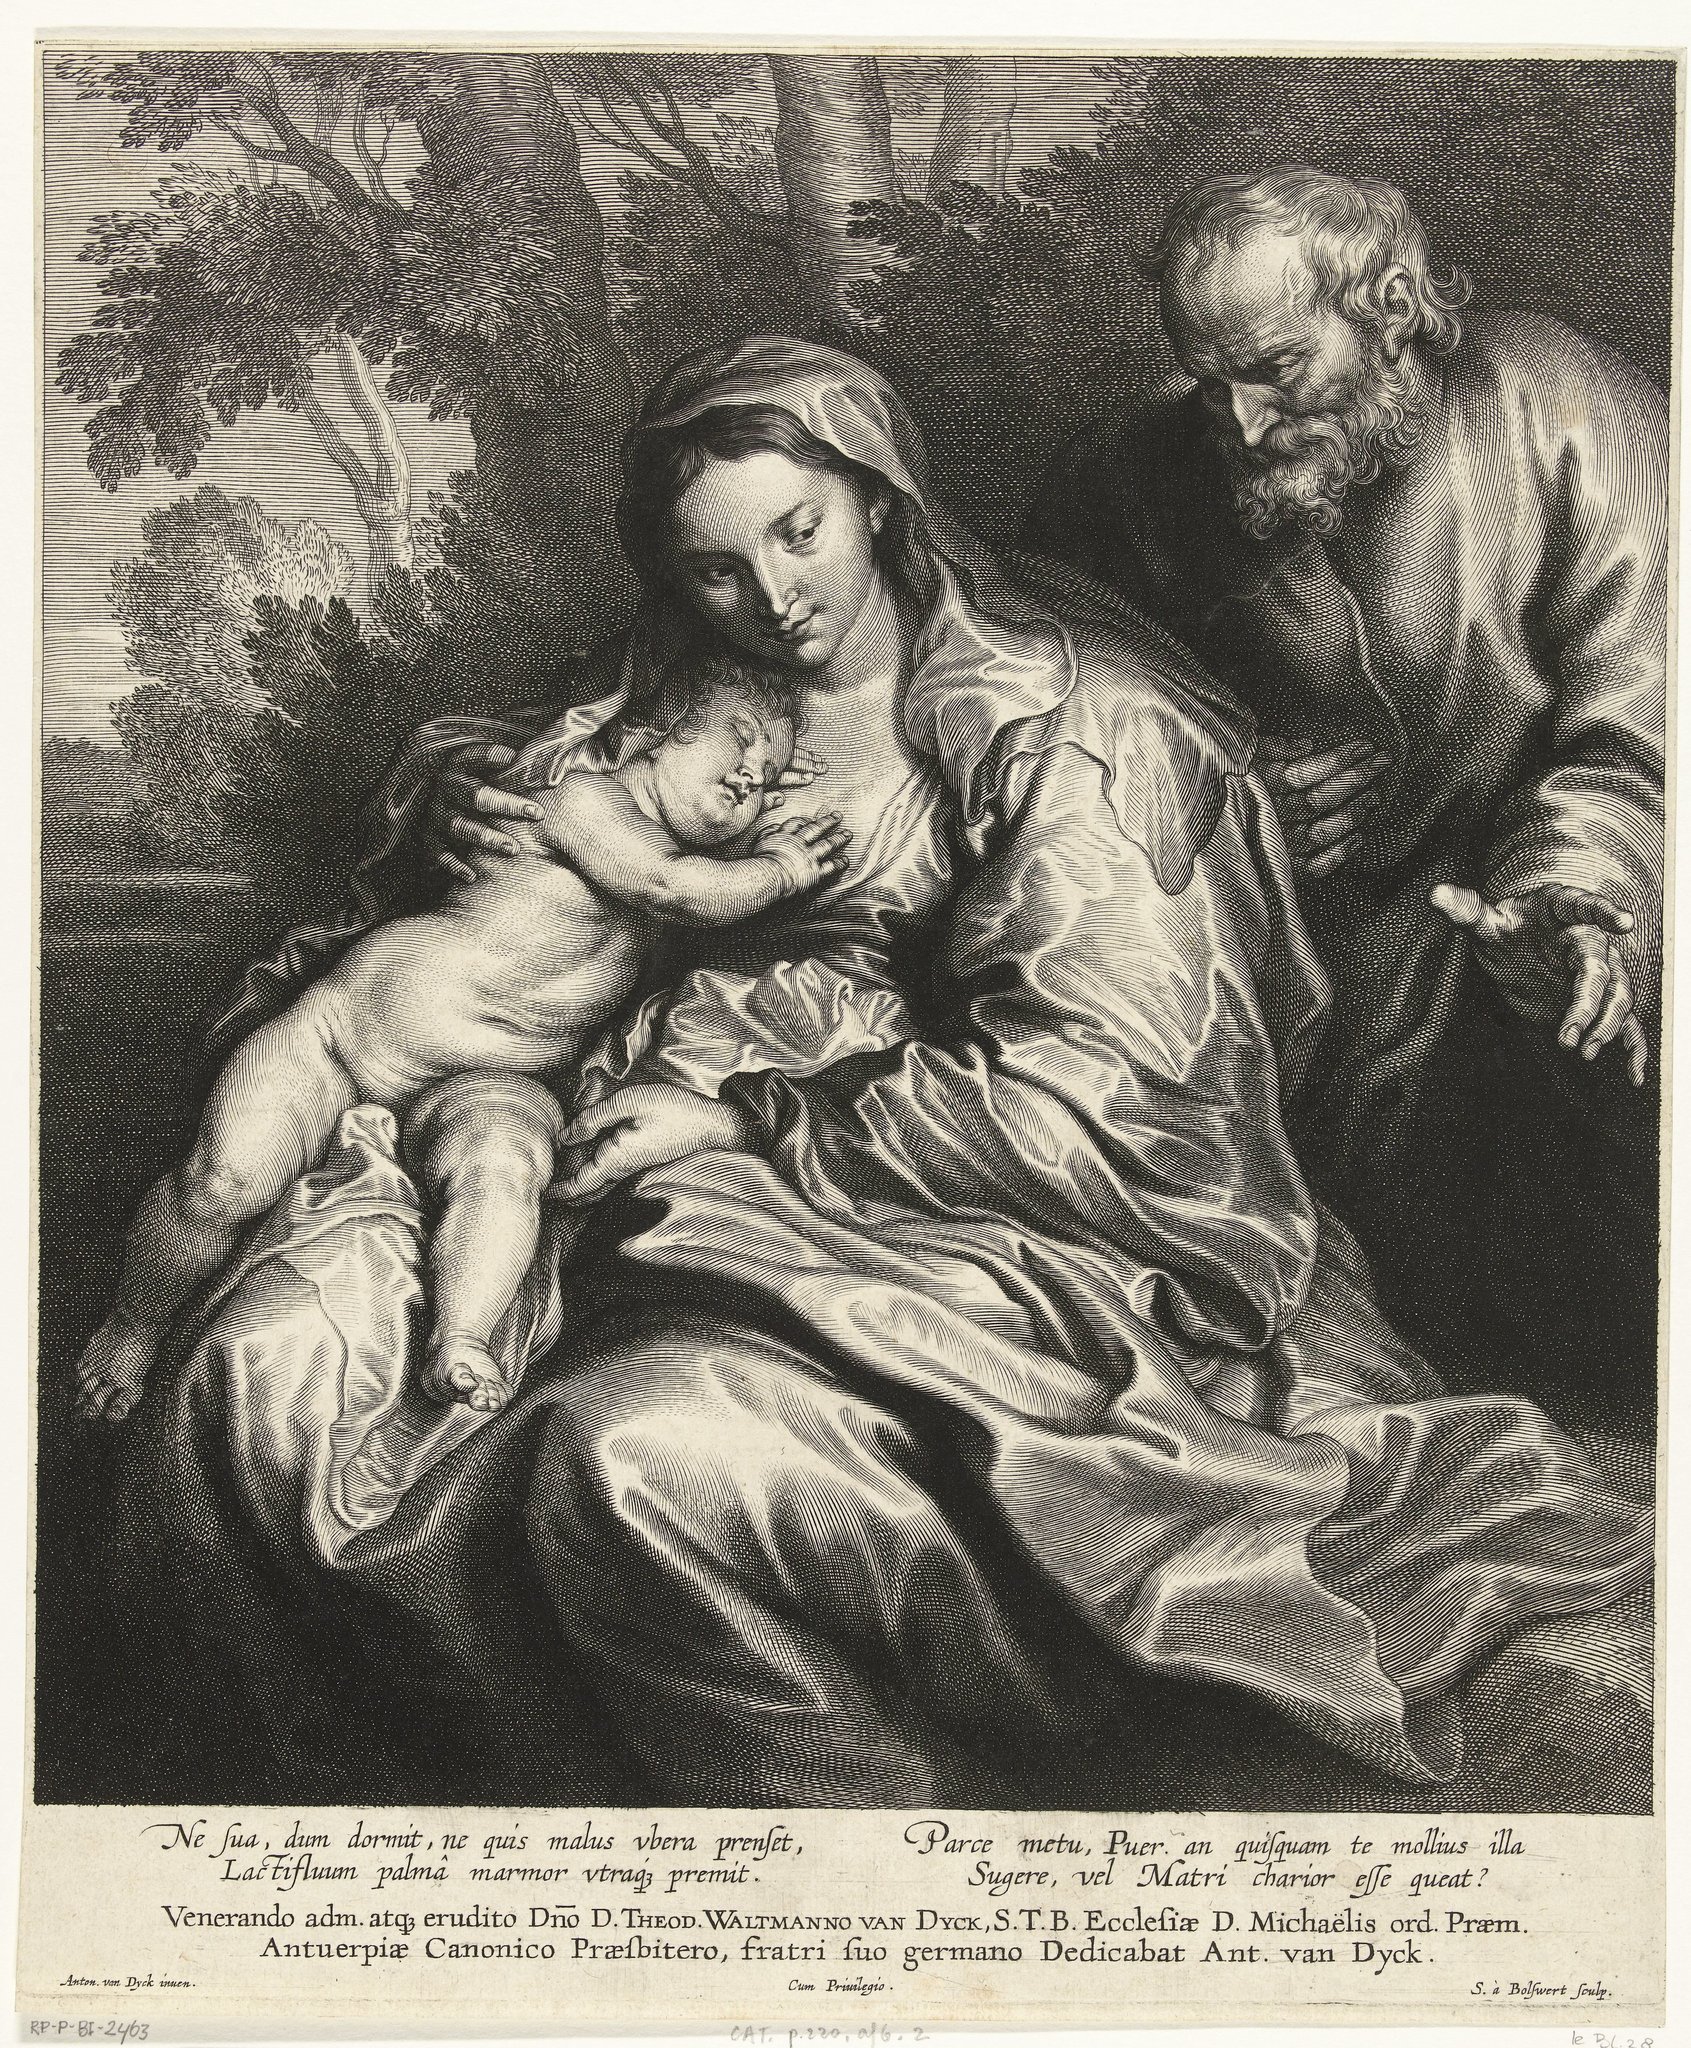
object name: print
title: Rest on the Flight into Egypt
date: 1596-1659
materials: paper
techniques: engraving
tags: rest on the flight into egypt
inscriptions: collector's mark: Lugt 240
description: Heilige Familie rust tijdens de vlucht naar Egypte. Onder de voorstelling staat een vers in Latijn.